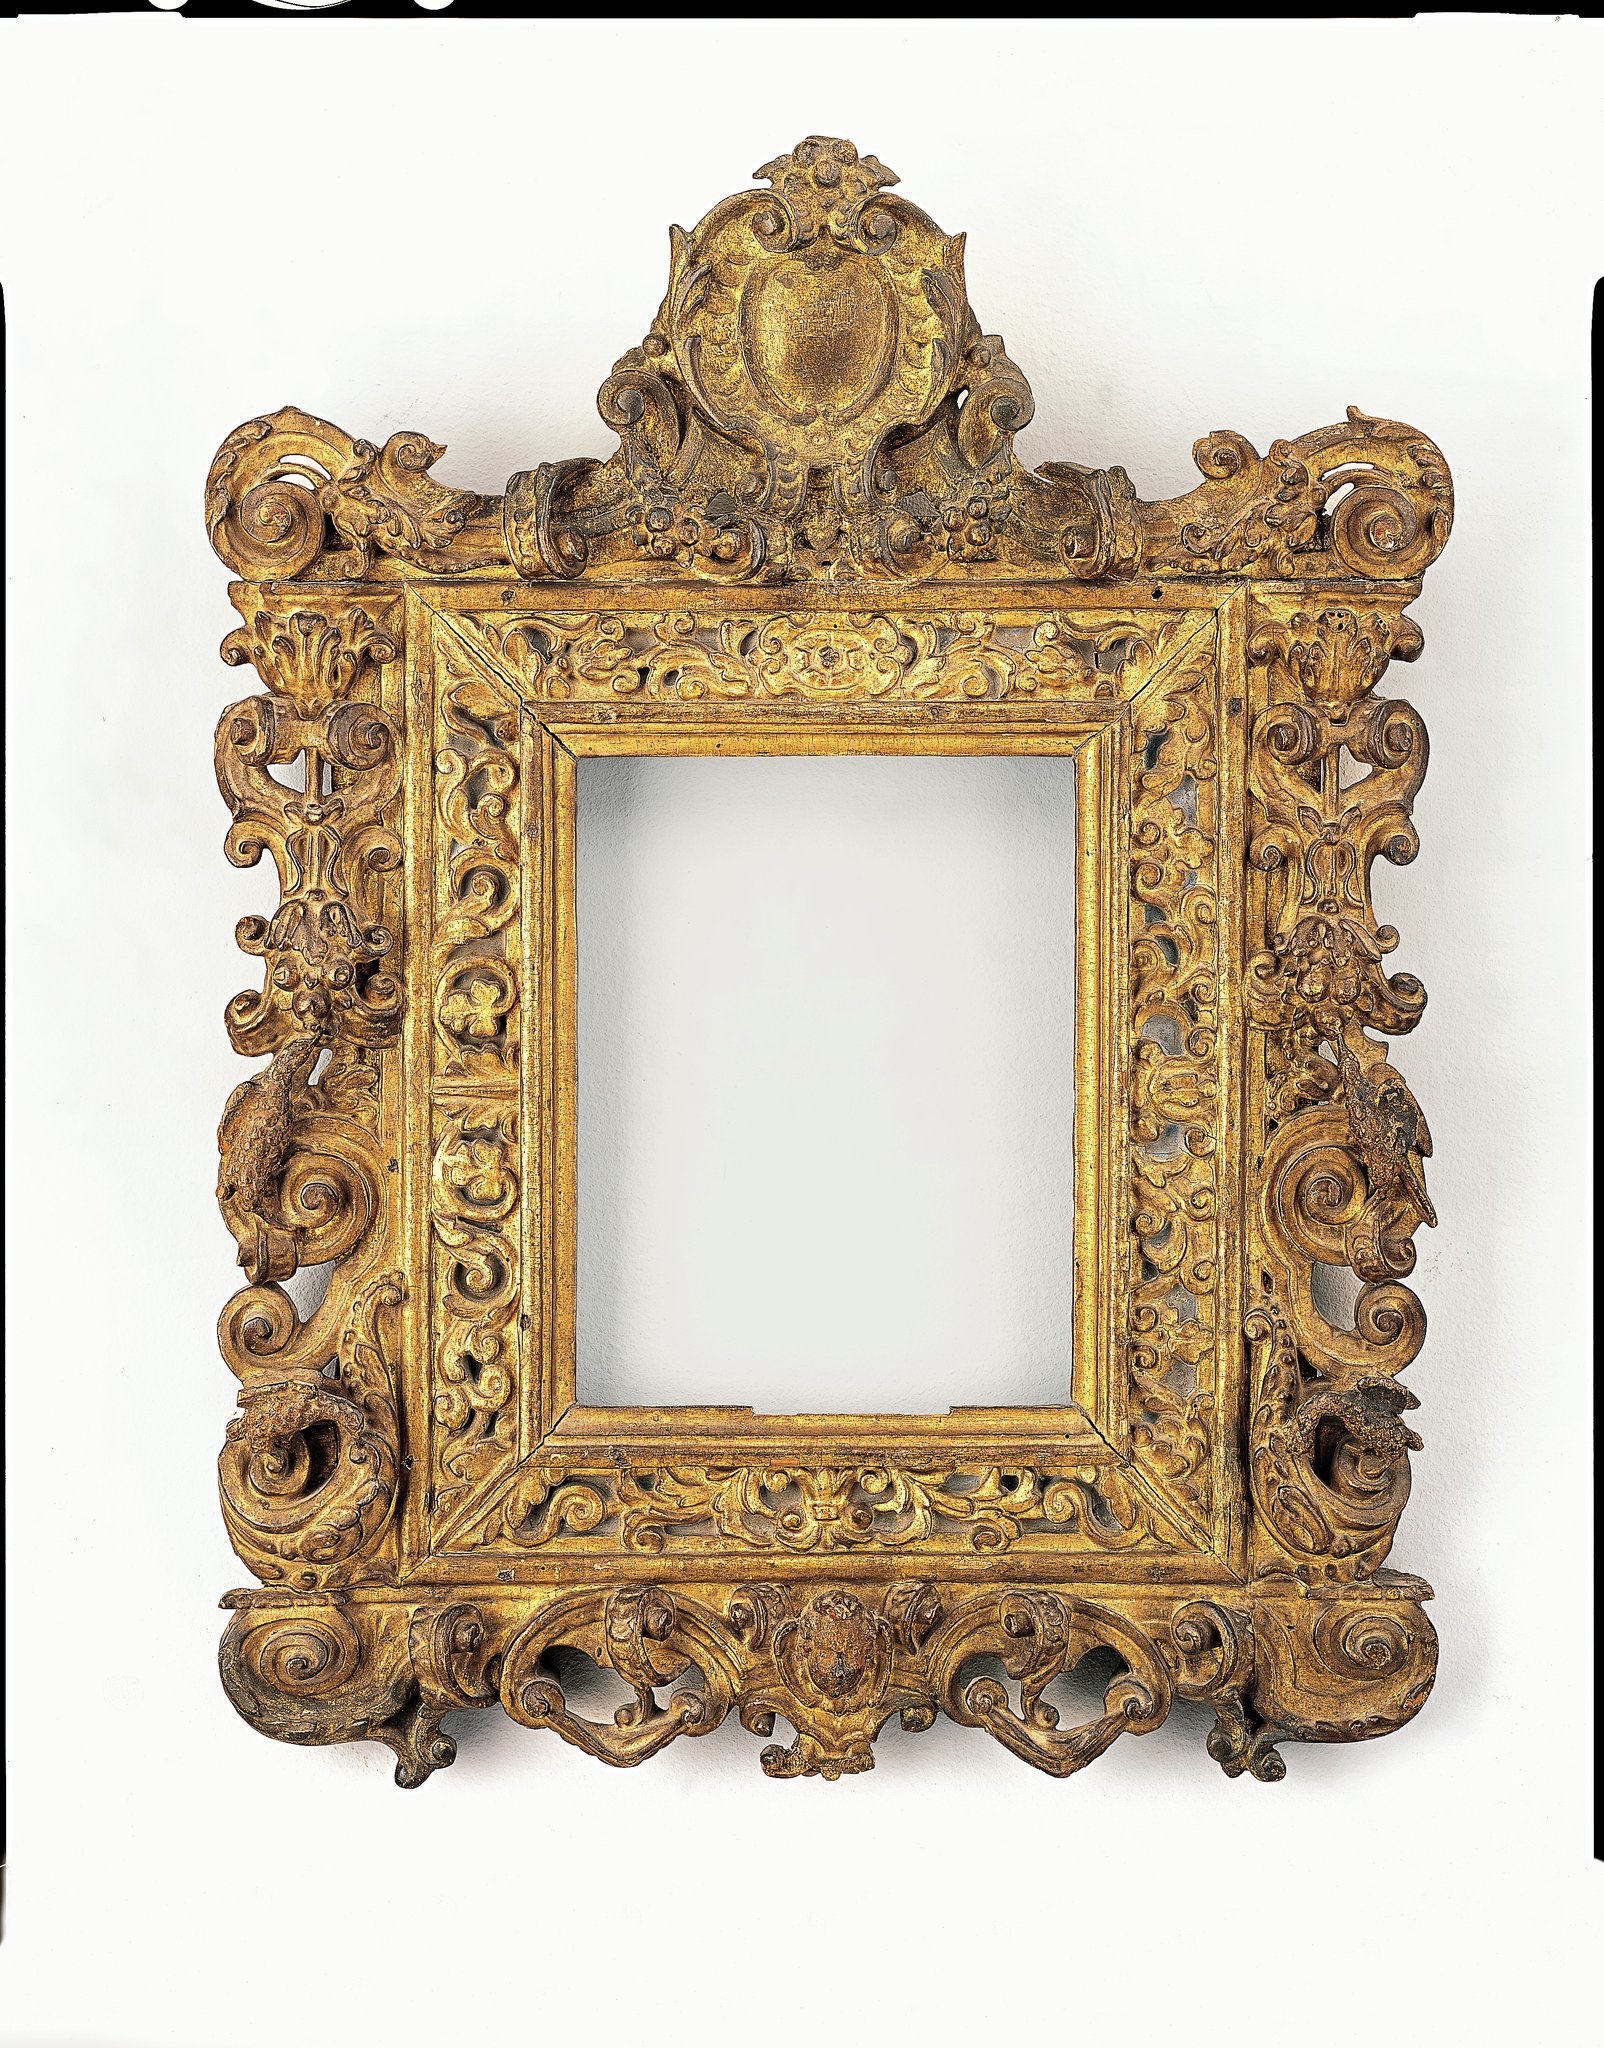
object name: frame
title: Sansovino-style frame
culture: italian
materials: wood